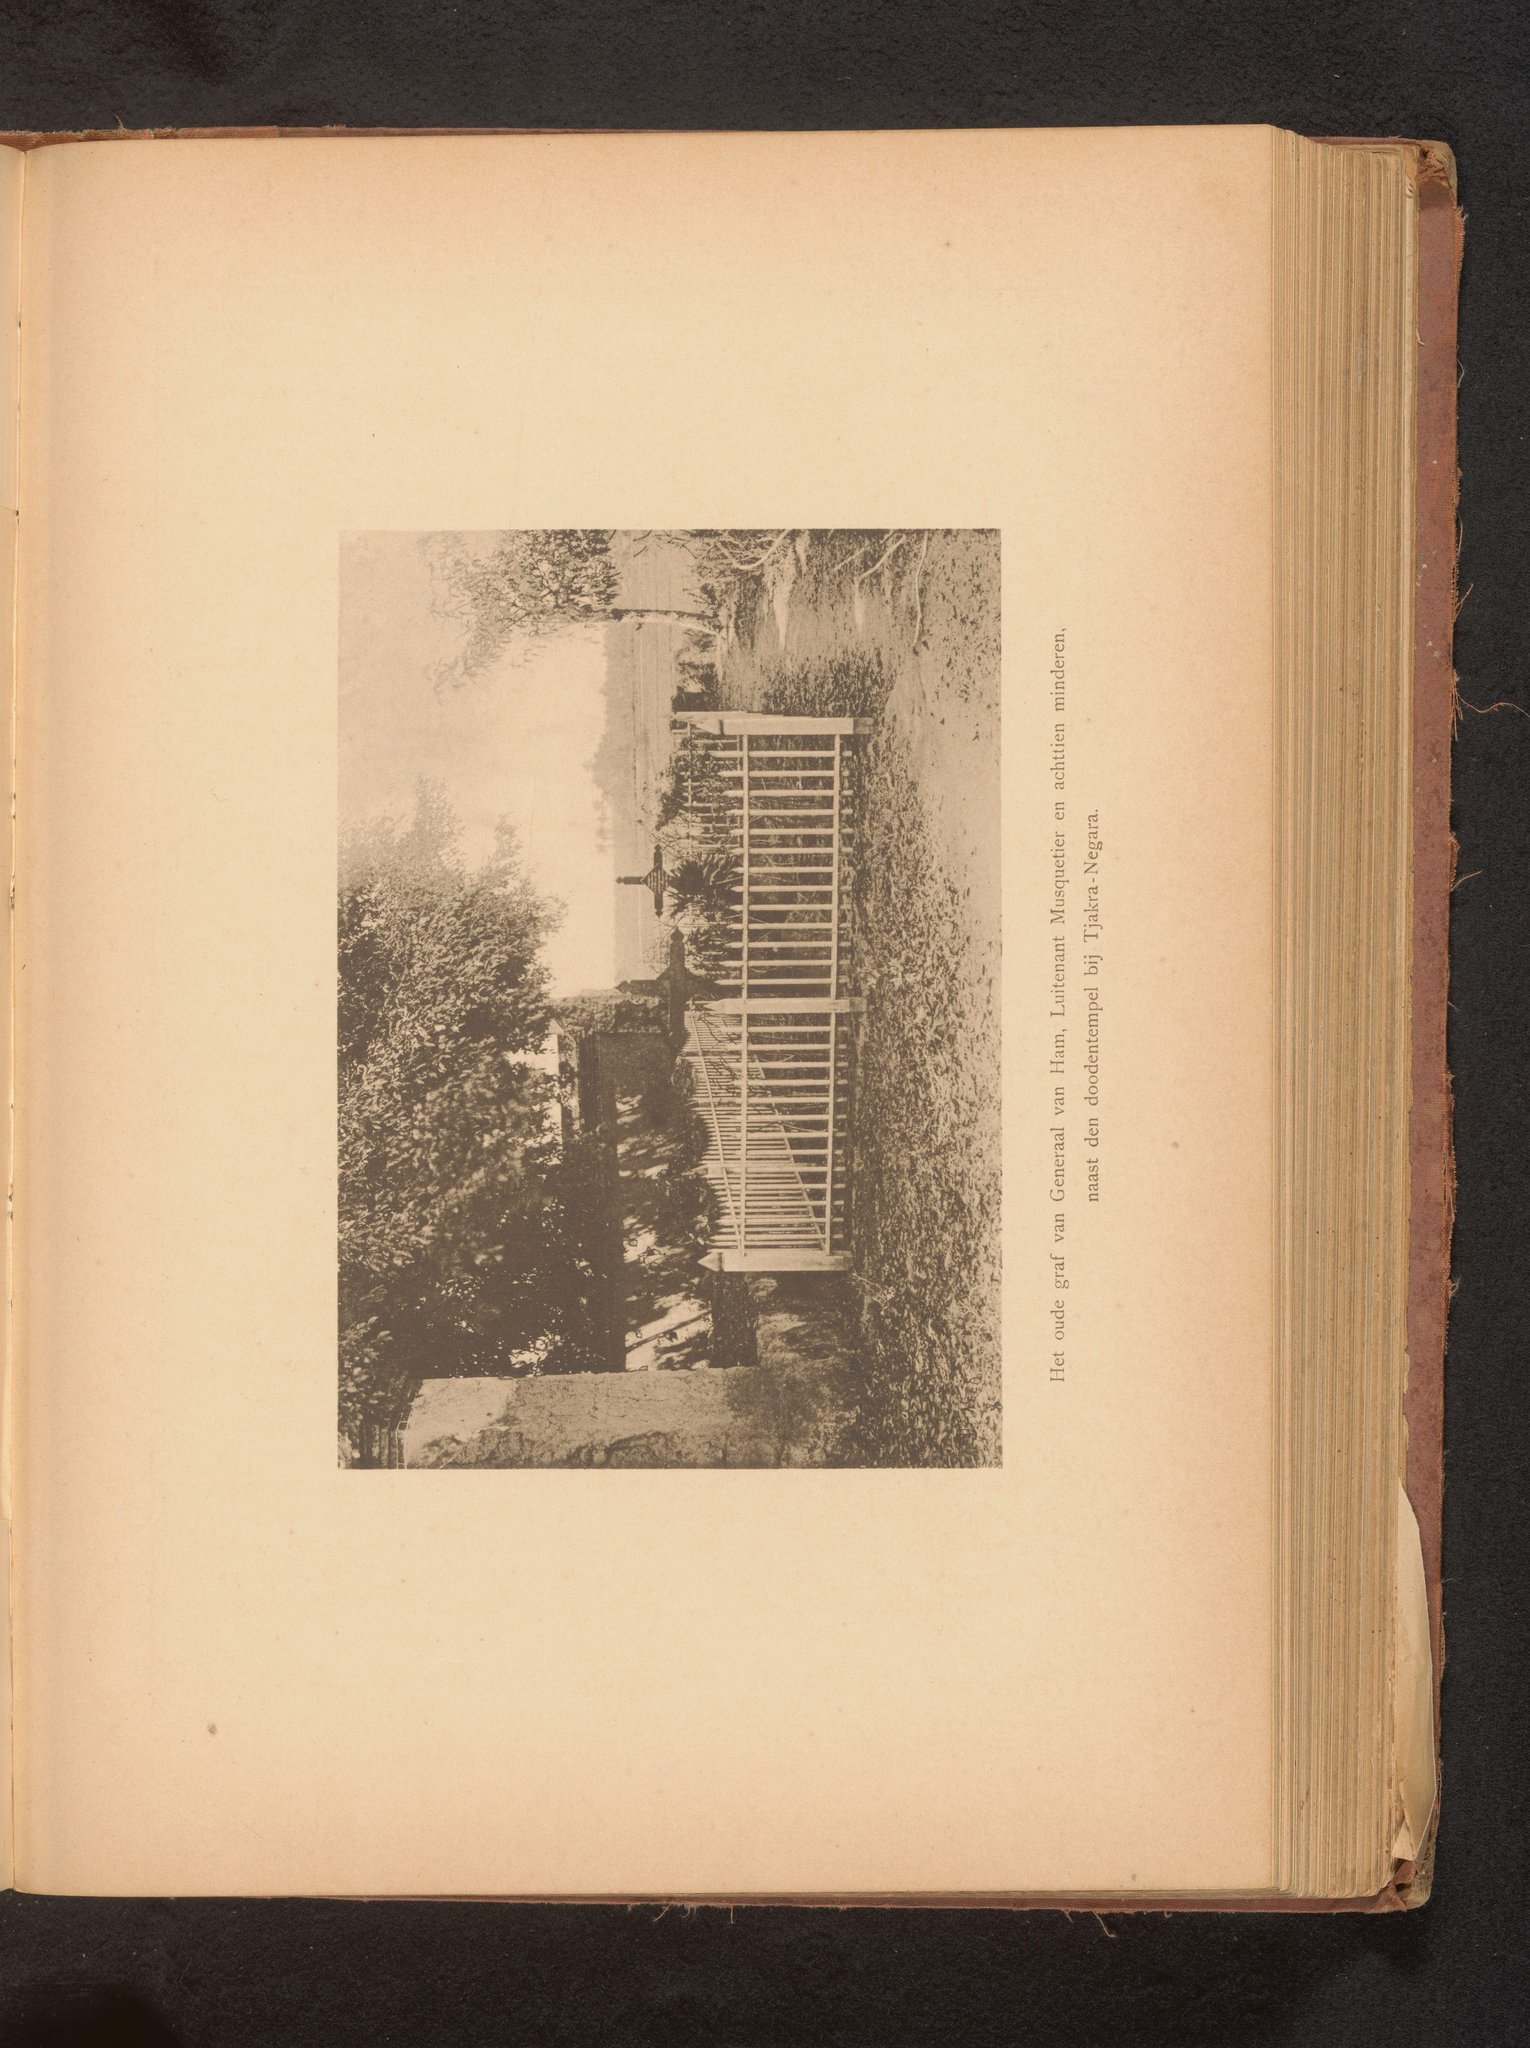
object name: photomechanical print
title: Gezicht op verschillende graven, waaronder die van Generaal van Ham en Luitenant Musquetier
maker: christiaan johan neeb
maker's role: arts, fotograaf, officier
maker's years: 1860-1925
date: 1892-1897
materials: paper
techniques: photograph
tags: grave, tomb, indonesia